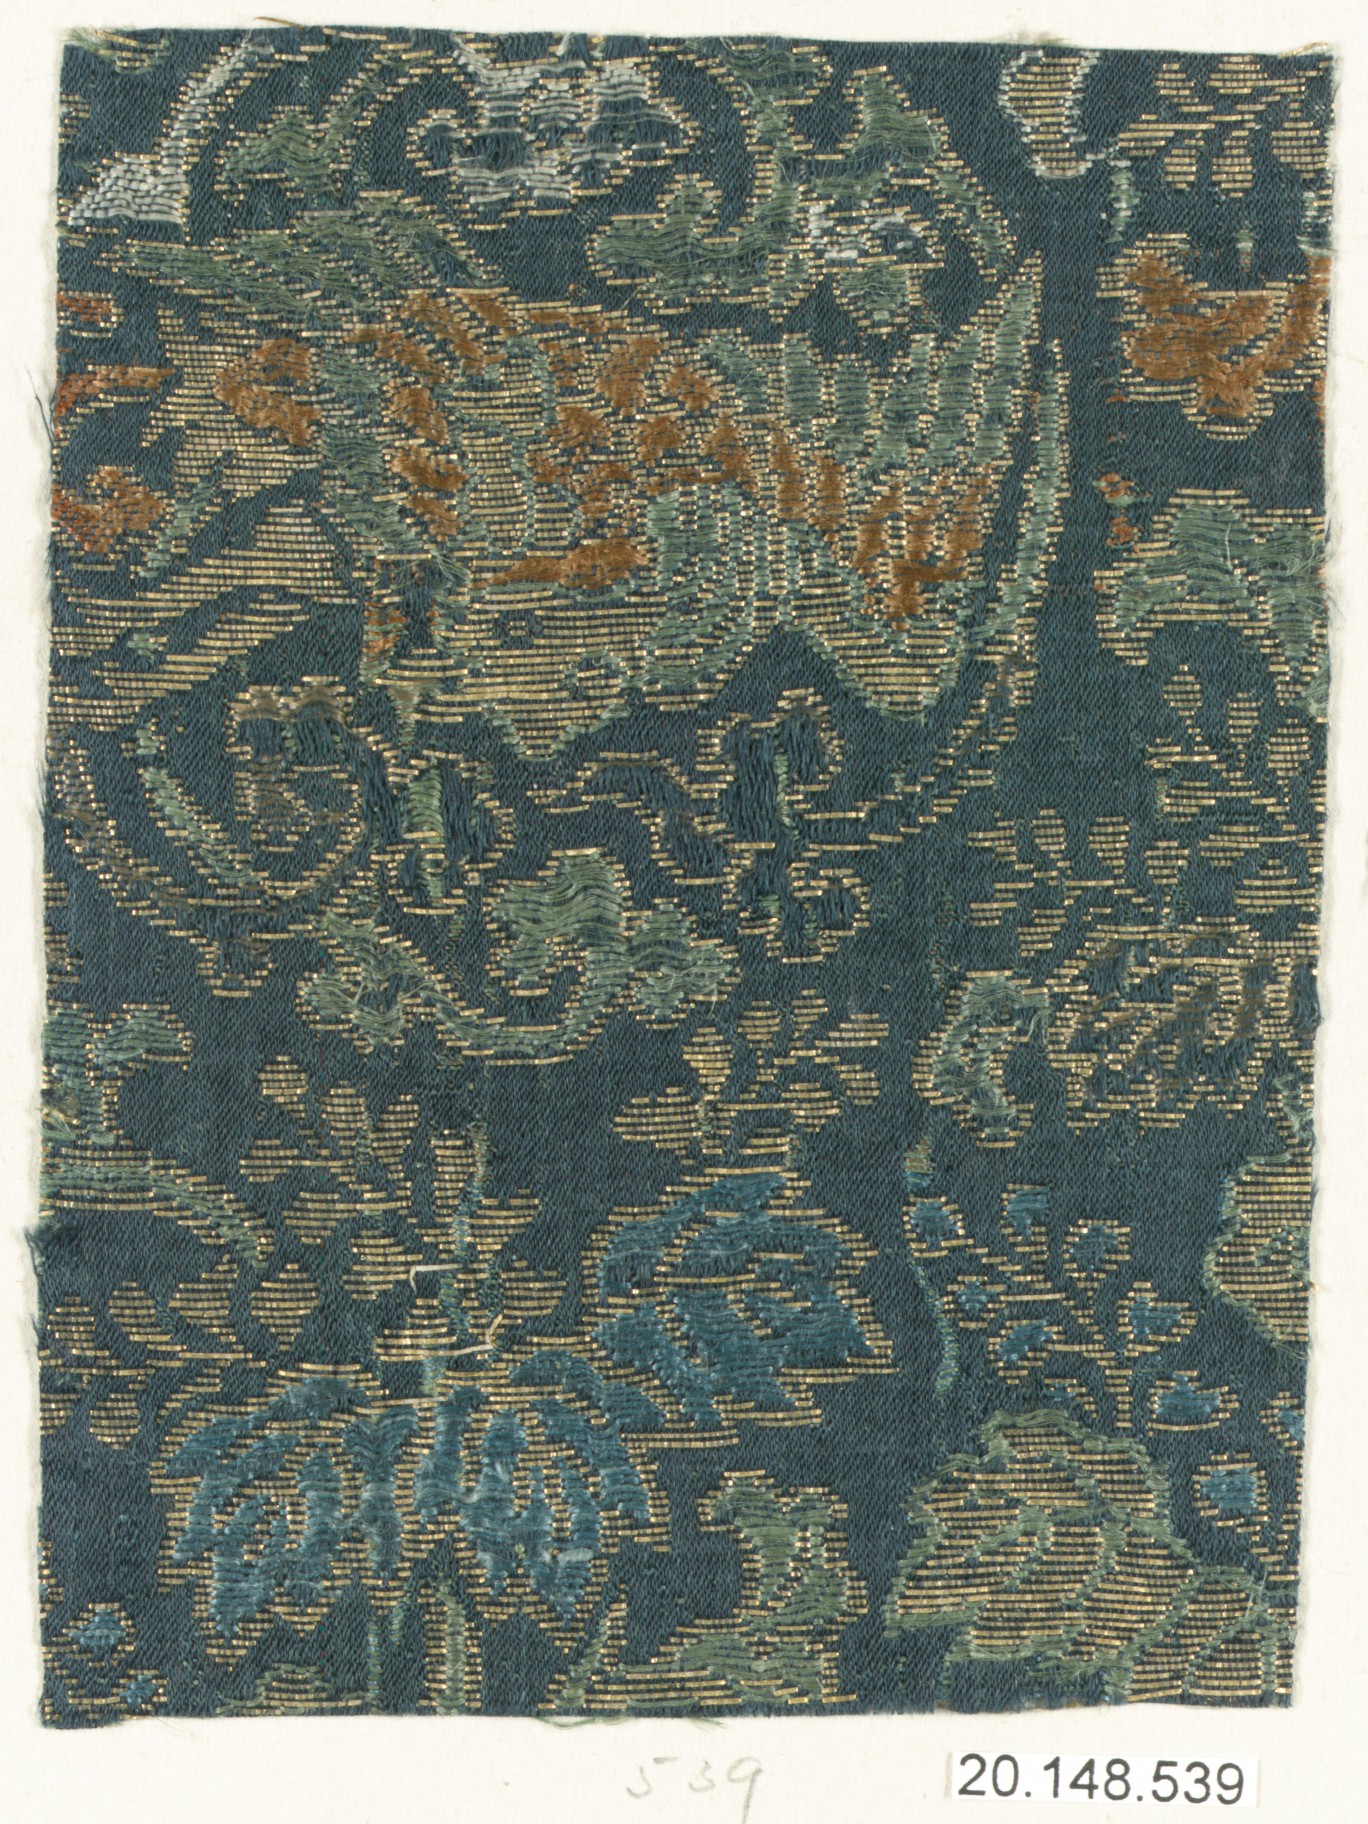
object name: piece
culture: japanese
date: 1701-1800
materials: silk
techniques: compound weave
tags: leaves